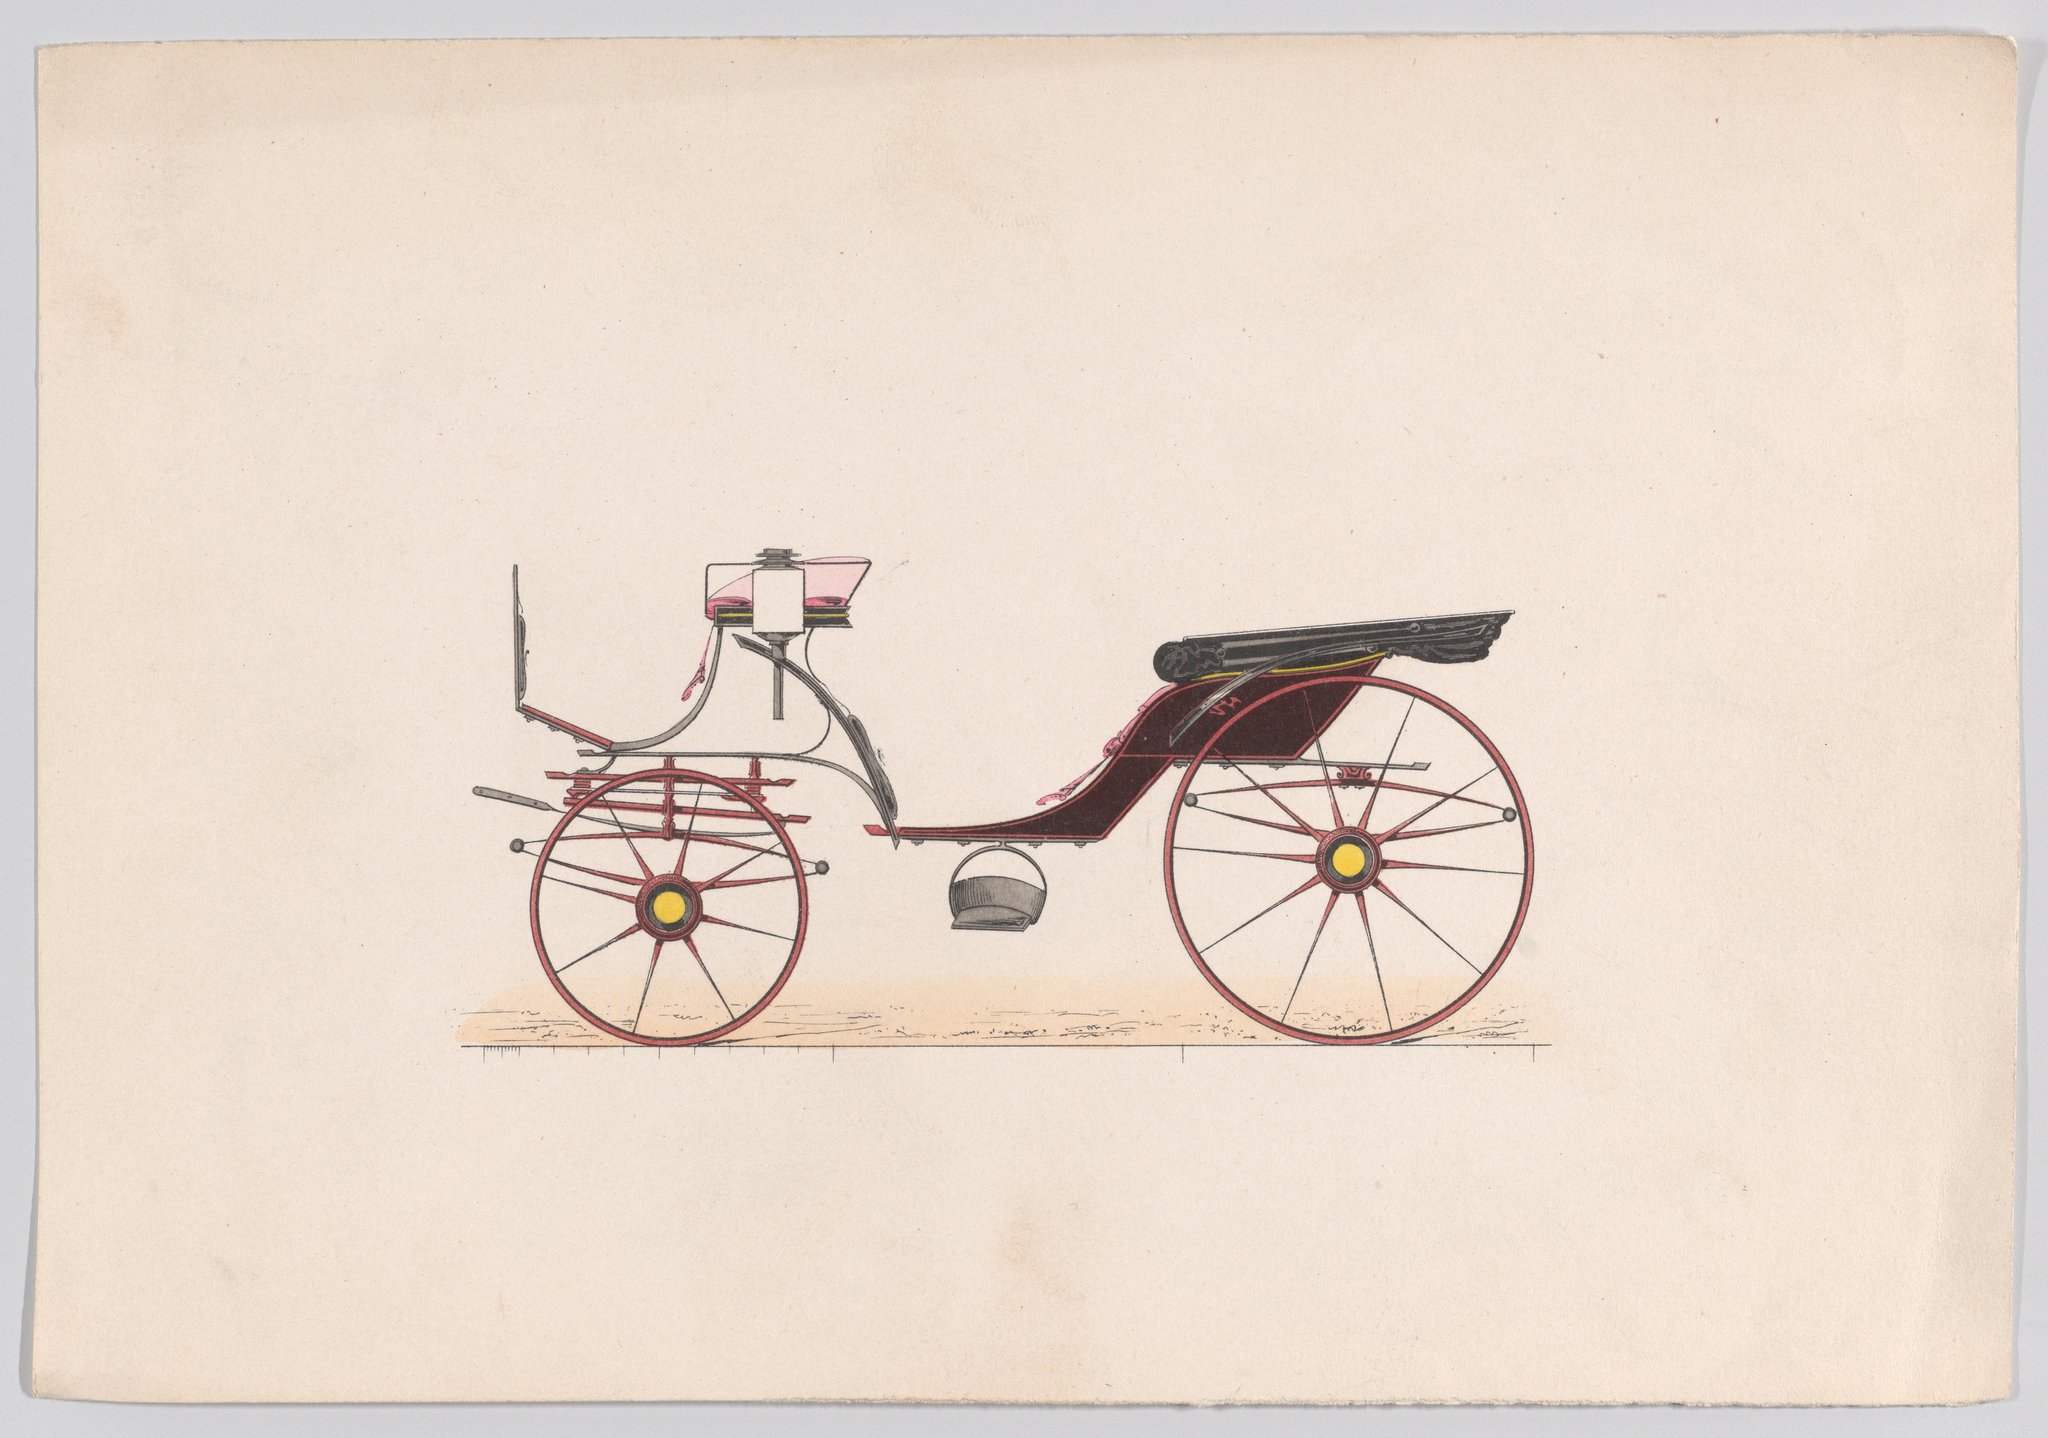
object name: print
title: Design for Cabriolet Carriage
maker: anonymous, french, 19th century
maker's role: artist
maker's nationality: french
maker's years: 1800-1900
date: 1870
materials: gum arabic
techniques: hand coloring, lithograph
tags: carriages